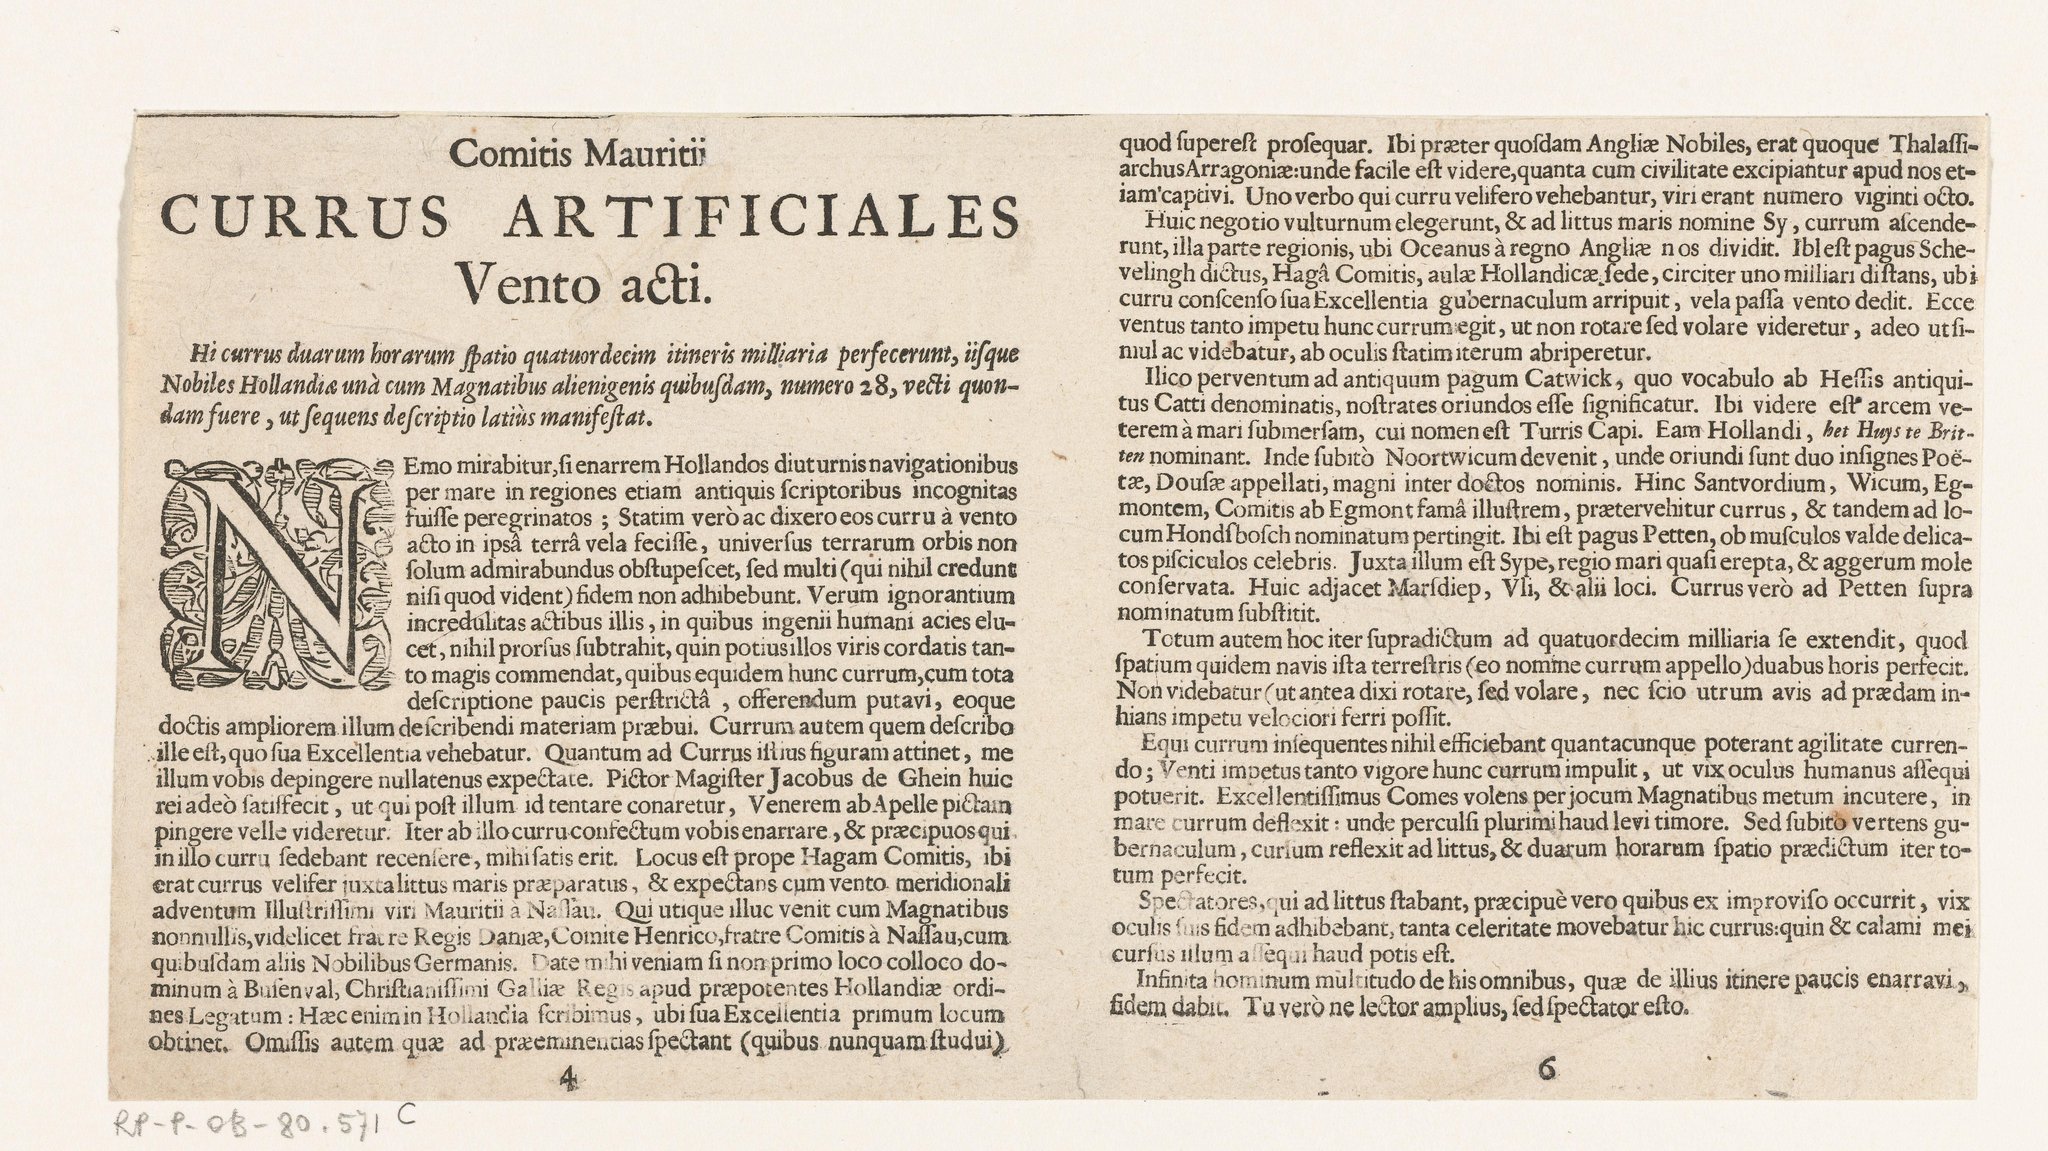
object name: text sheet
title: Toelichting van de werking van de zeilwagen van Simon Stevin, 1602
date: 1603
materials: paper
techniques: letterpress printing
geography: amsterdam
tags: the hague, maurice (prince of orange), bruges, simon stevin, sailing-car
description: Toelichting van de werking van de zeilwagen van Simon Stevin, 1602. Twee kolommen tekst in het Latijn. Onderdelen genummerd 4 en 6. Met versierde initiaal N. Dit blad behoort losgesneden en aan de zijkanten en onderzijde van de grote prent van de zeilwagen in drie platen gemonteerd te worden.